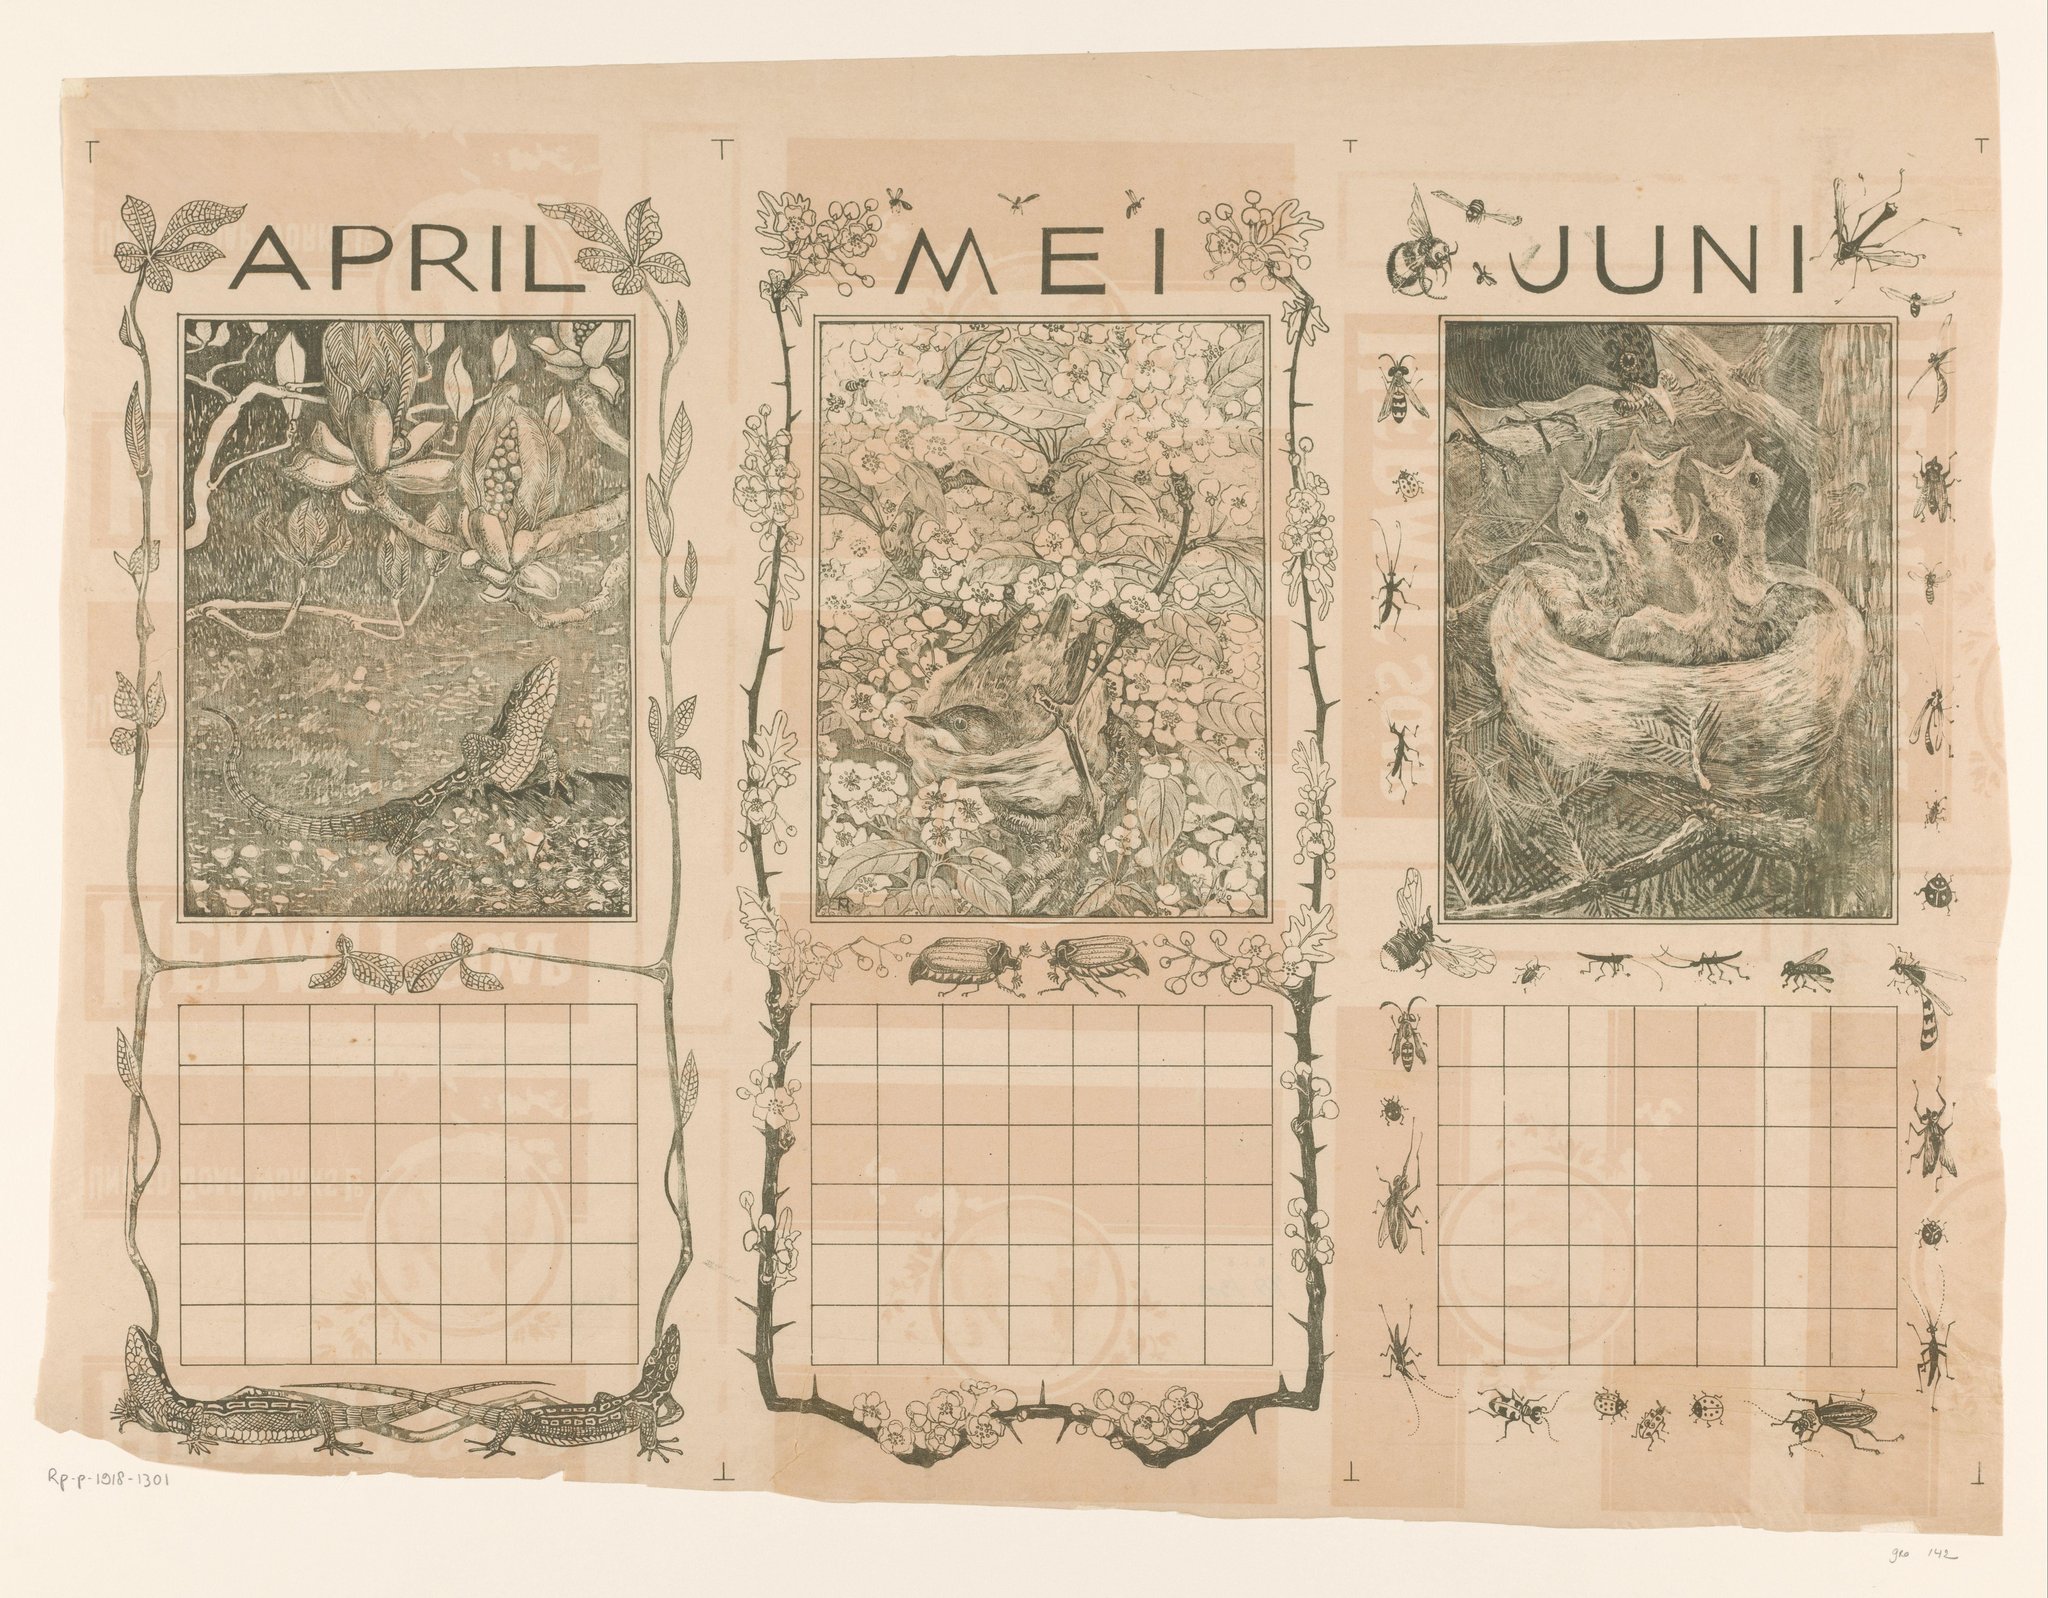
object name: print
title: Kalenderbladen van april, mei en juni, met hagedis en vogels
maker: theo van hoytema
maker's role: draughtsman, painter, print maker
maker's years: 1863-1917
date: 1901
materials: paper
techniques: lithograph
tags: calendar, almanac, lizards, birds